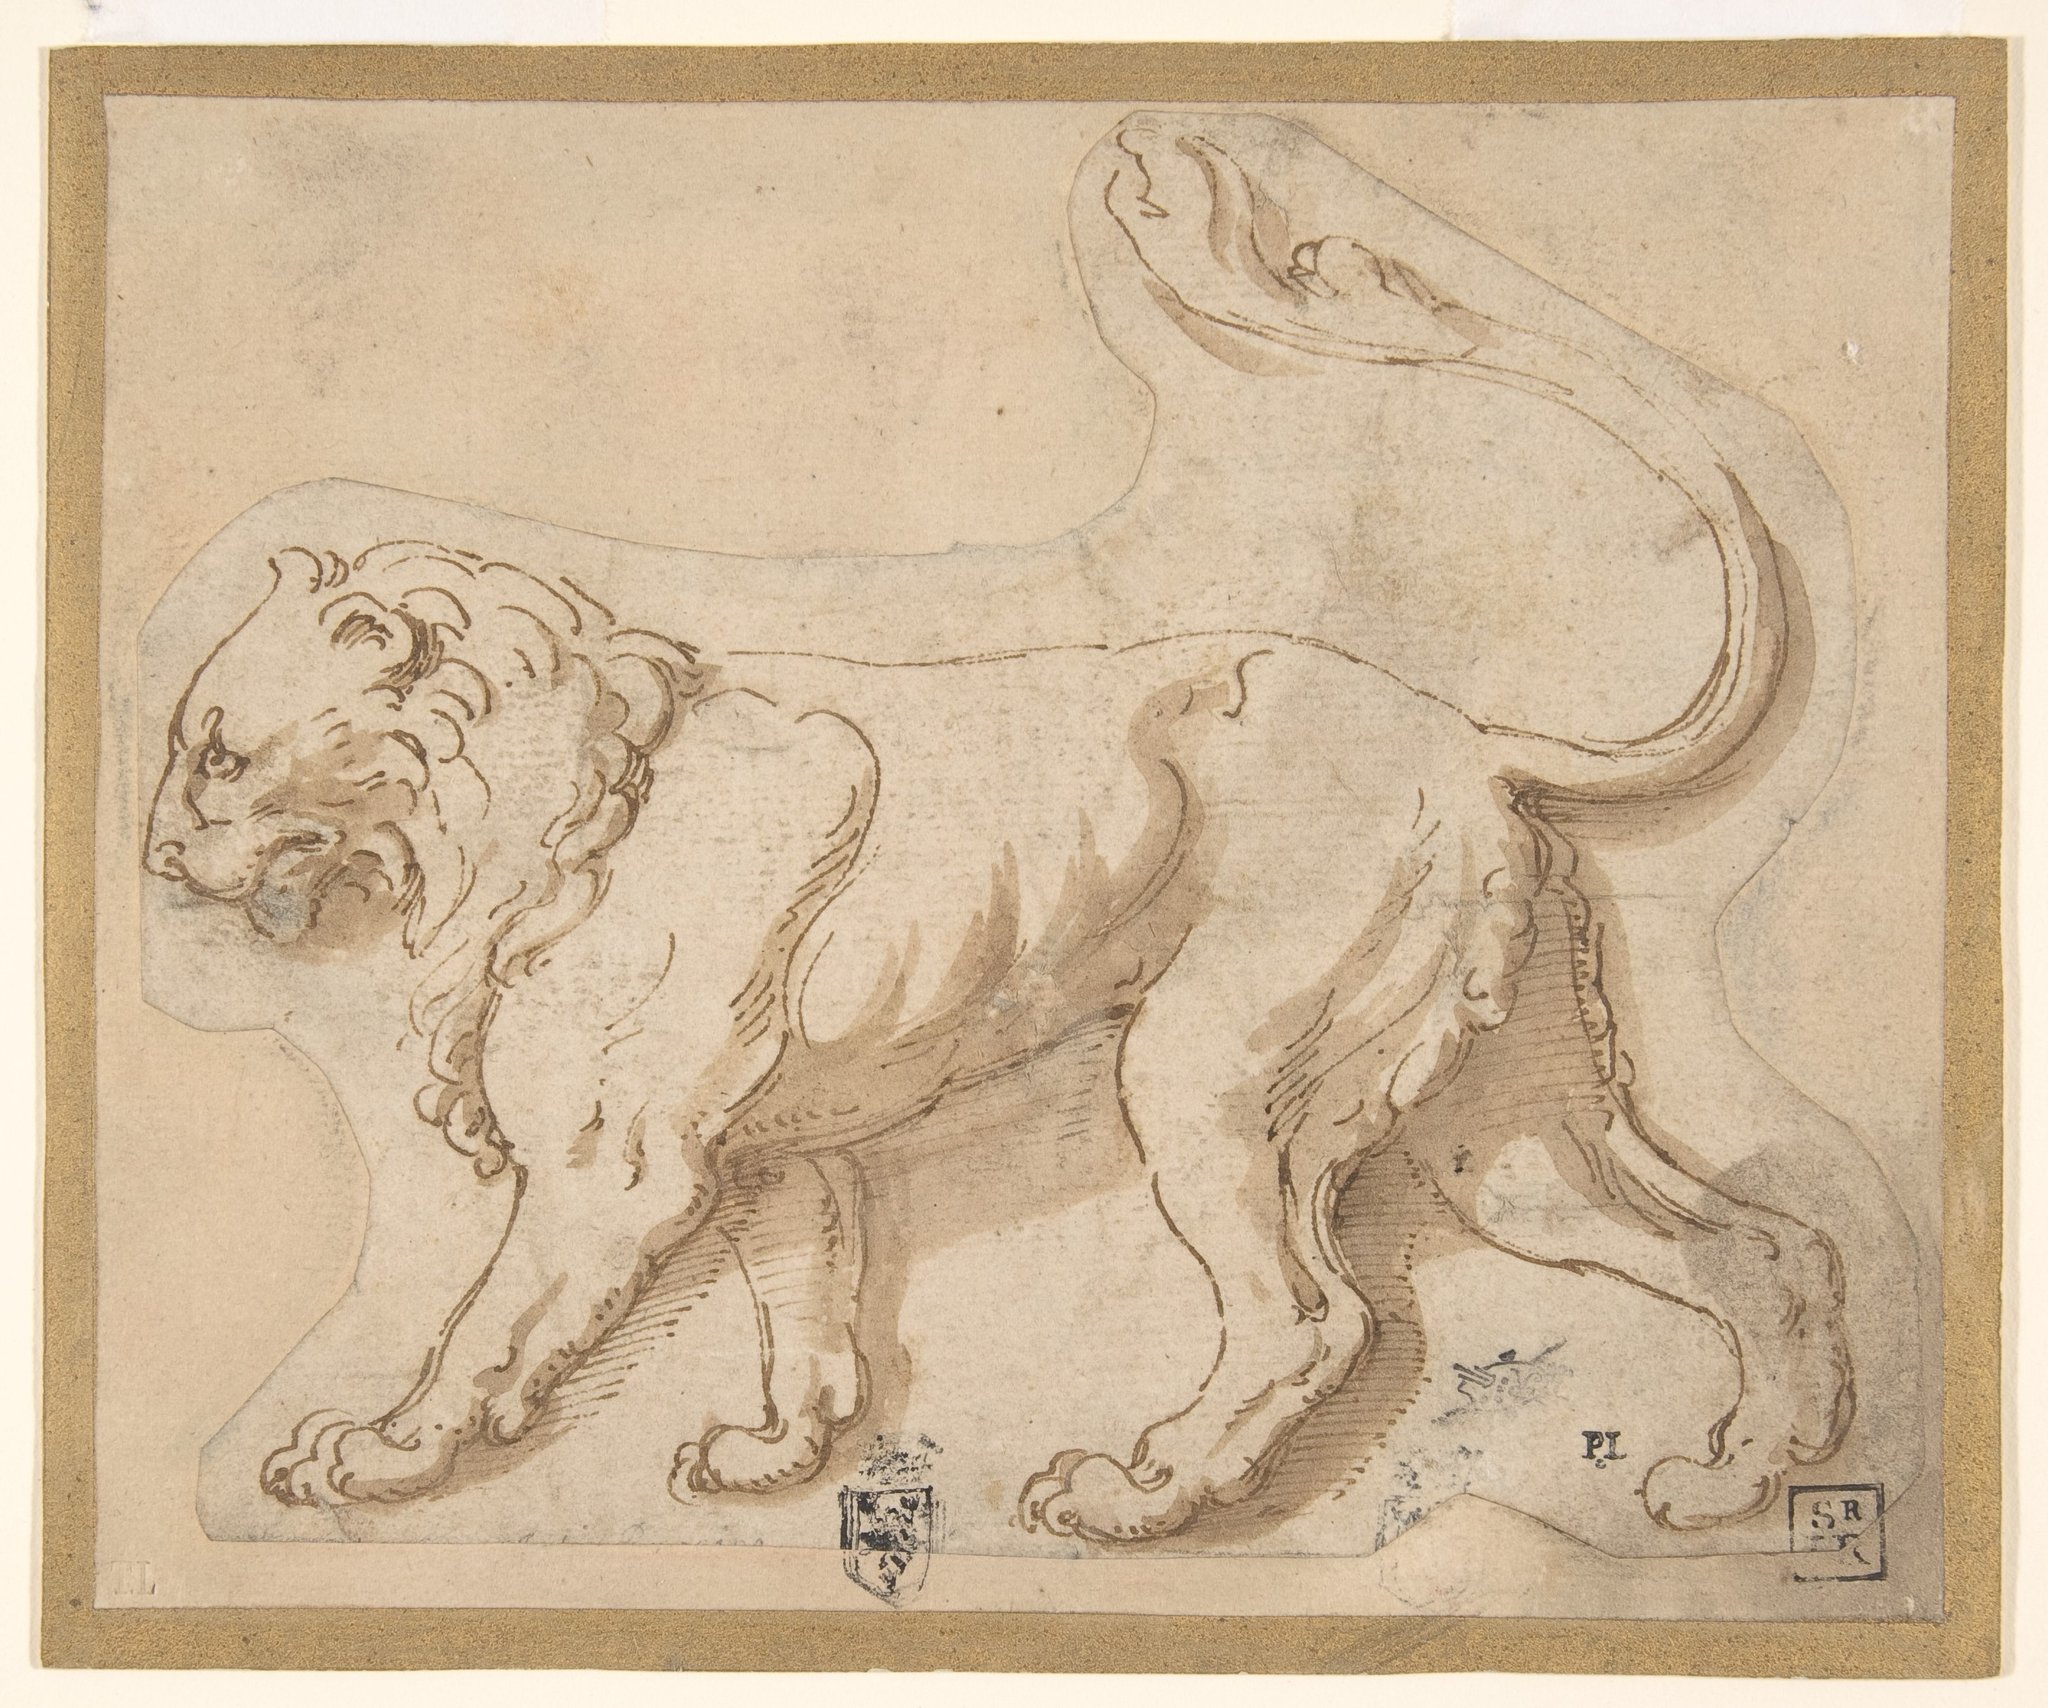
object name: drawing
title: A Lion in Profile Facing to the Left ("Leo")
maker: giulio romano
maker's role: artist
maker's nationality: italian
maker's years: 1499-1546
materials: chalk, ink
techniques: brush, pen, wash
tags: lions